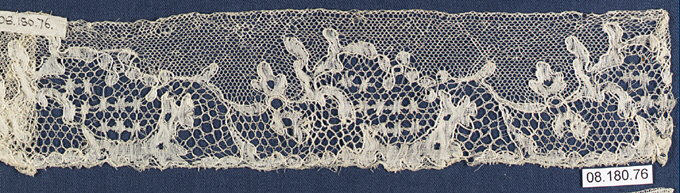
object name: fragment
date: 1801-1900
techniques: lace